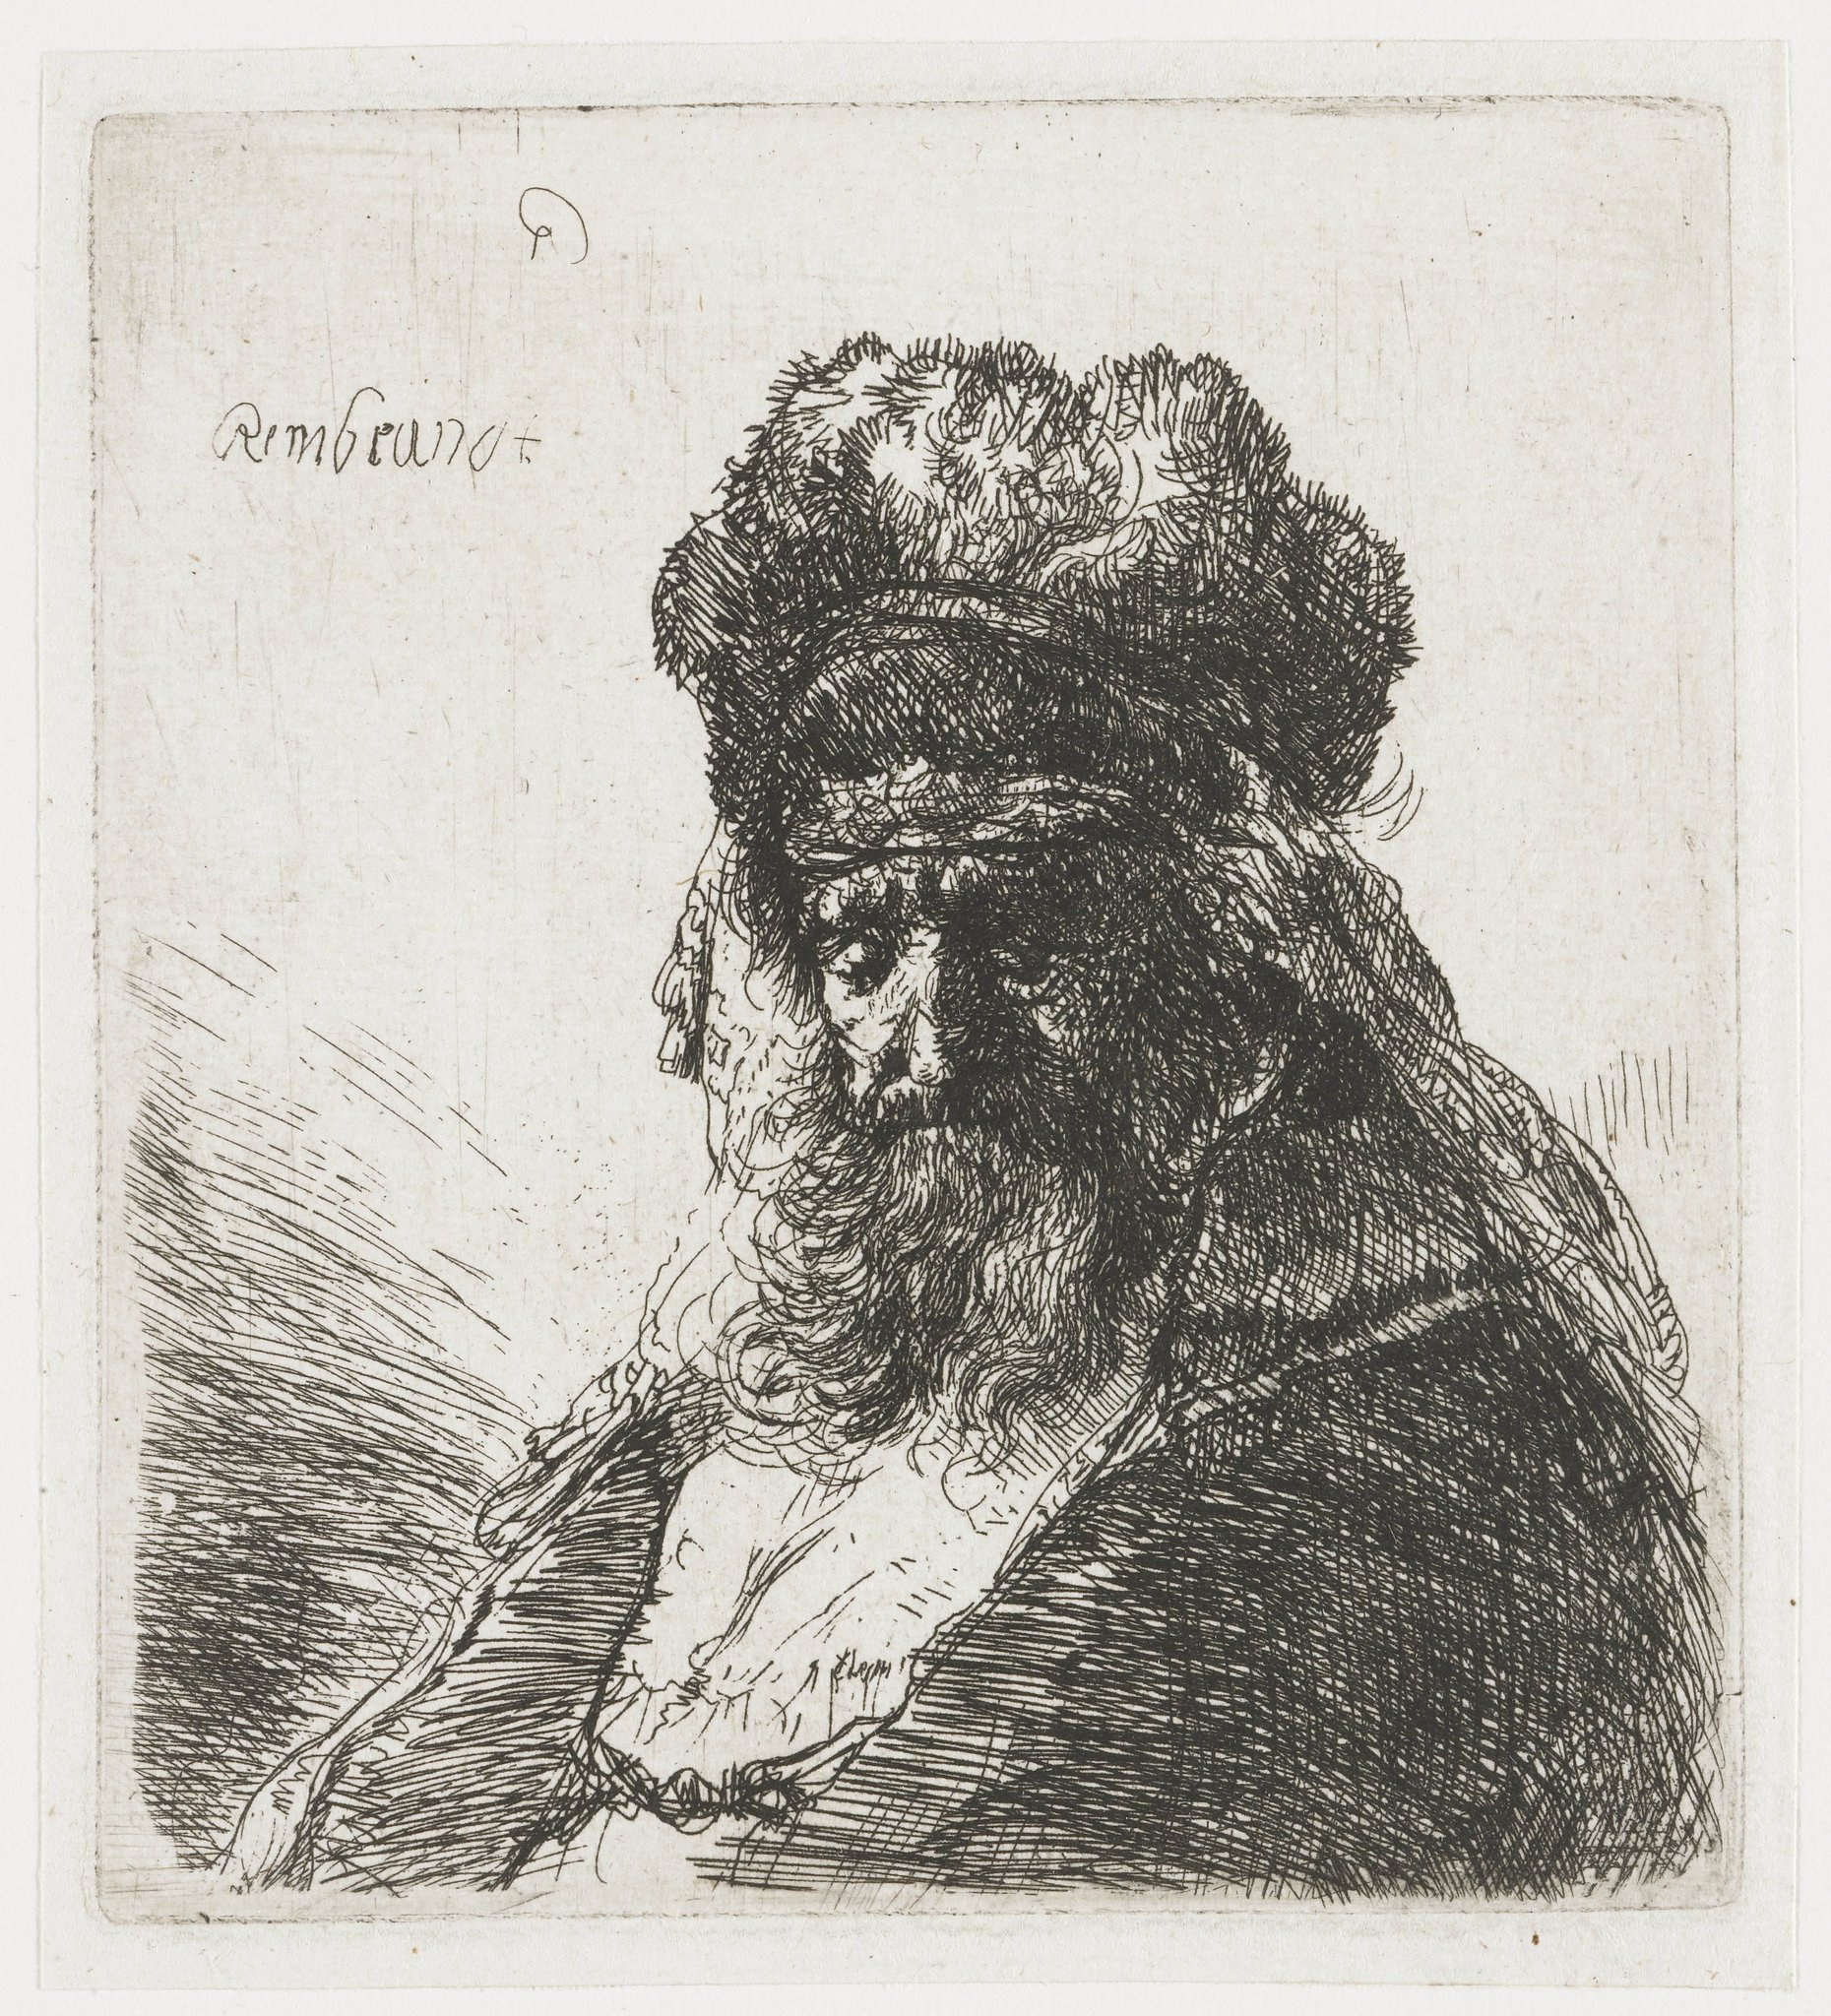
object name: print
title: Bearded old man in a high fur cap, with eyes closed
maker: rembrandt van rijn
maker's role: draughtsman, painter, print maker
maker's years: 1606-1669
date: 1635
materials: paper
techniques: etching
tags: head-gear (with name)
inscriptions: signature: ‘Rembrandt’, collector's mark: Lugt 240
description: While Rembrandt did not etch this man after a model by Jan Lievens, the depiction and execution are very close to the other four prints after him on view here. The man wears a fur cap bound on his head by means of a scarf, the ends of which hang down over his shoulders. His cloak is held together with a decorative fastening at his chest.